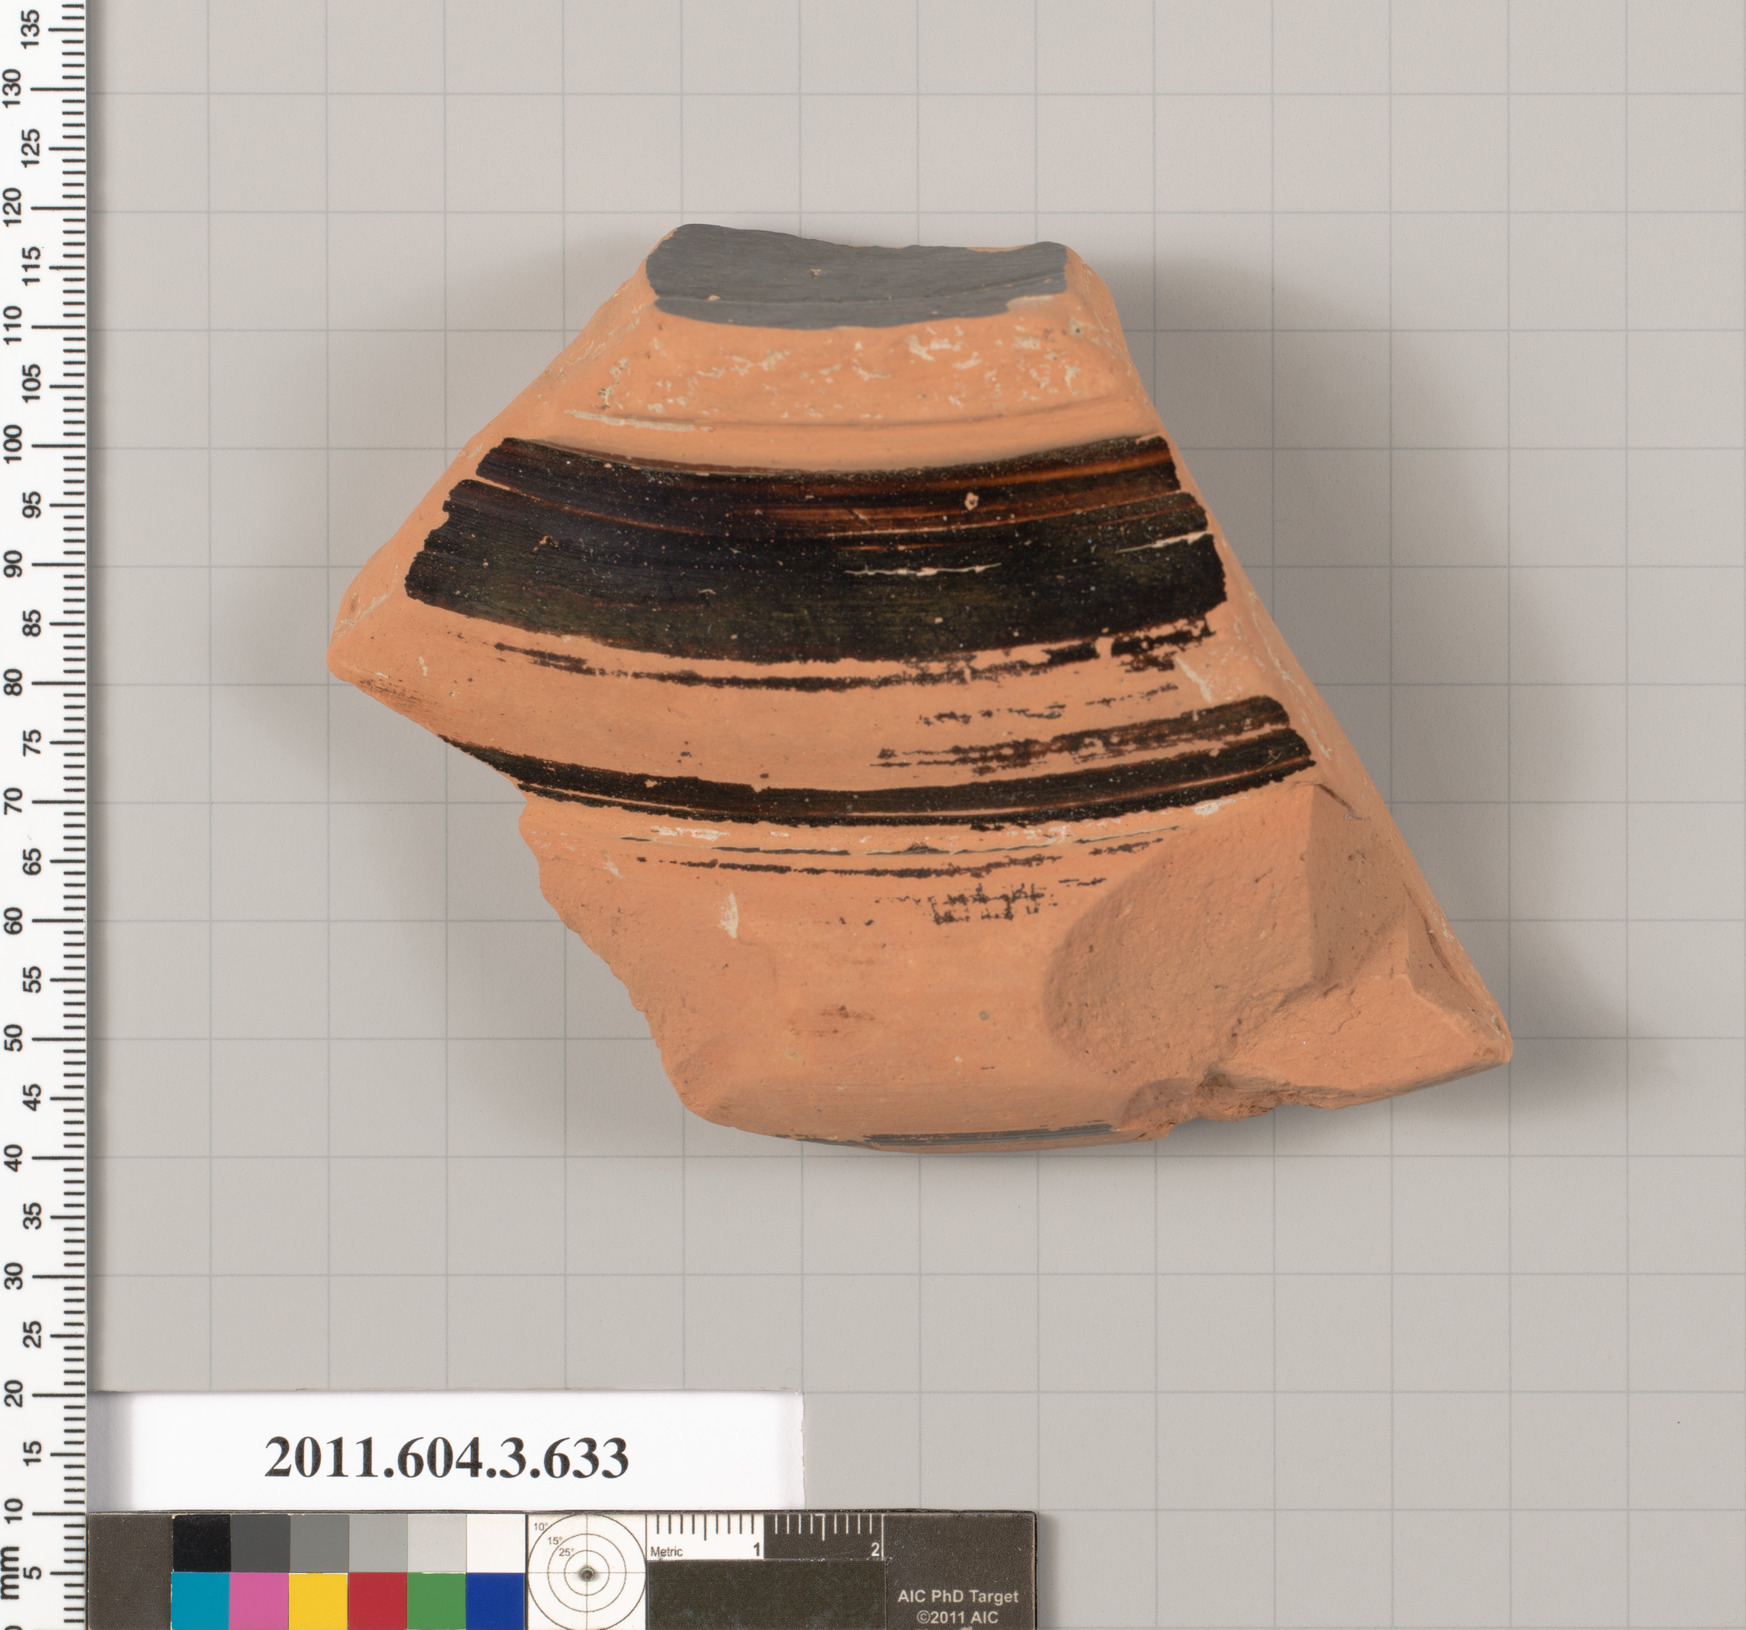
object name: column krater fragment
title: Terracotta fragment of a column-krater (bowl for mixing wine and water)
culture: greek, attic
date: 600-401 BCE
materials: terracotta